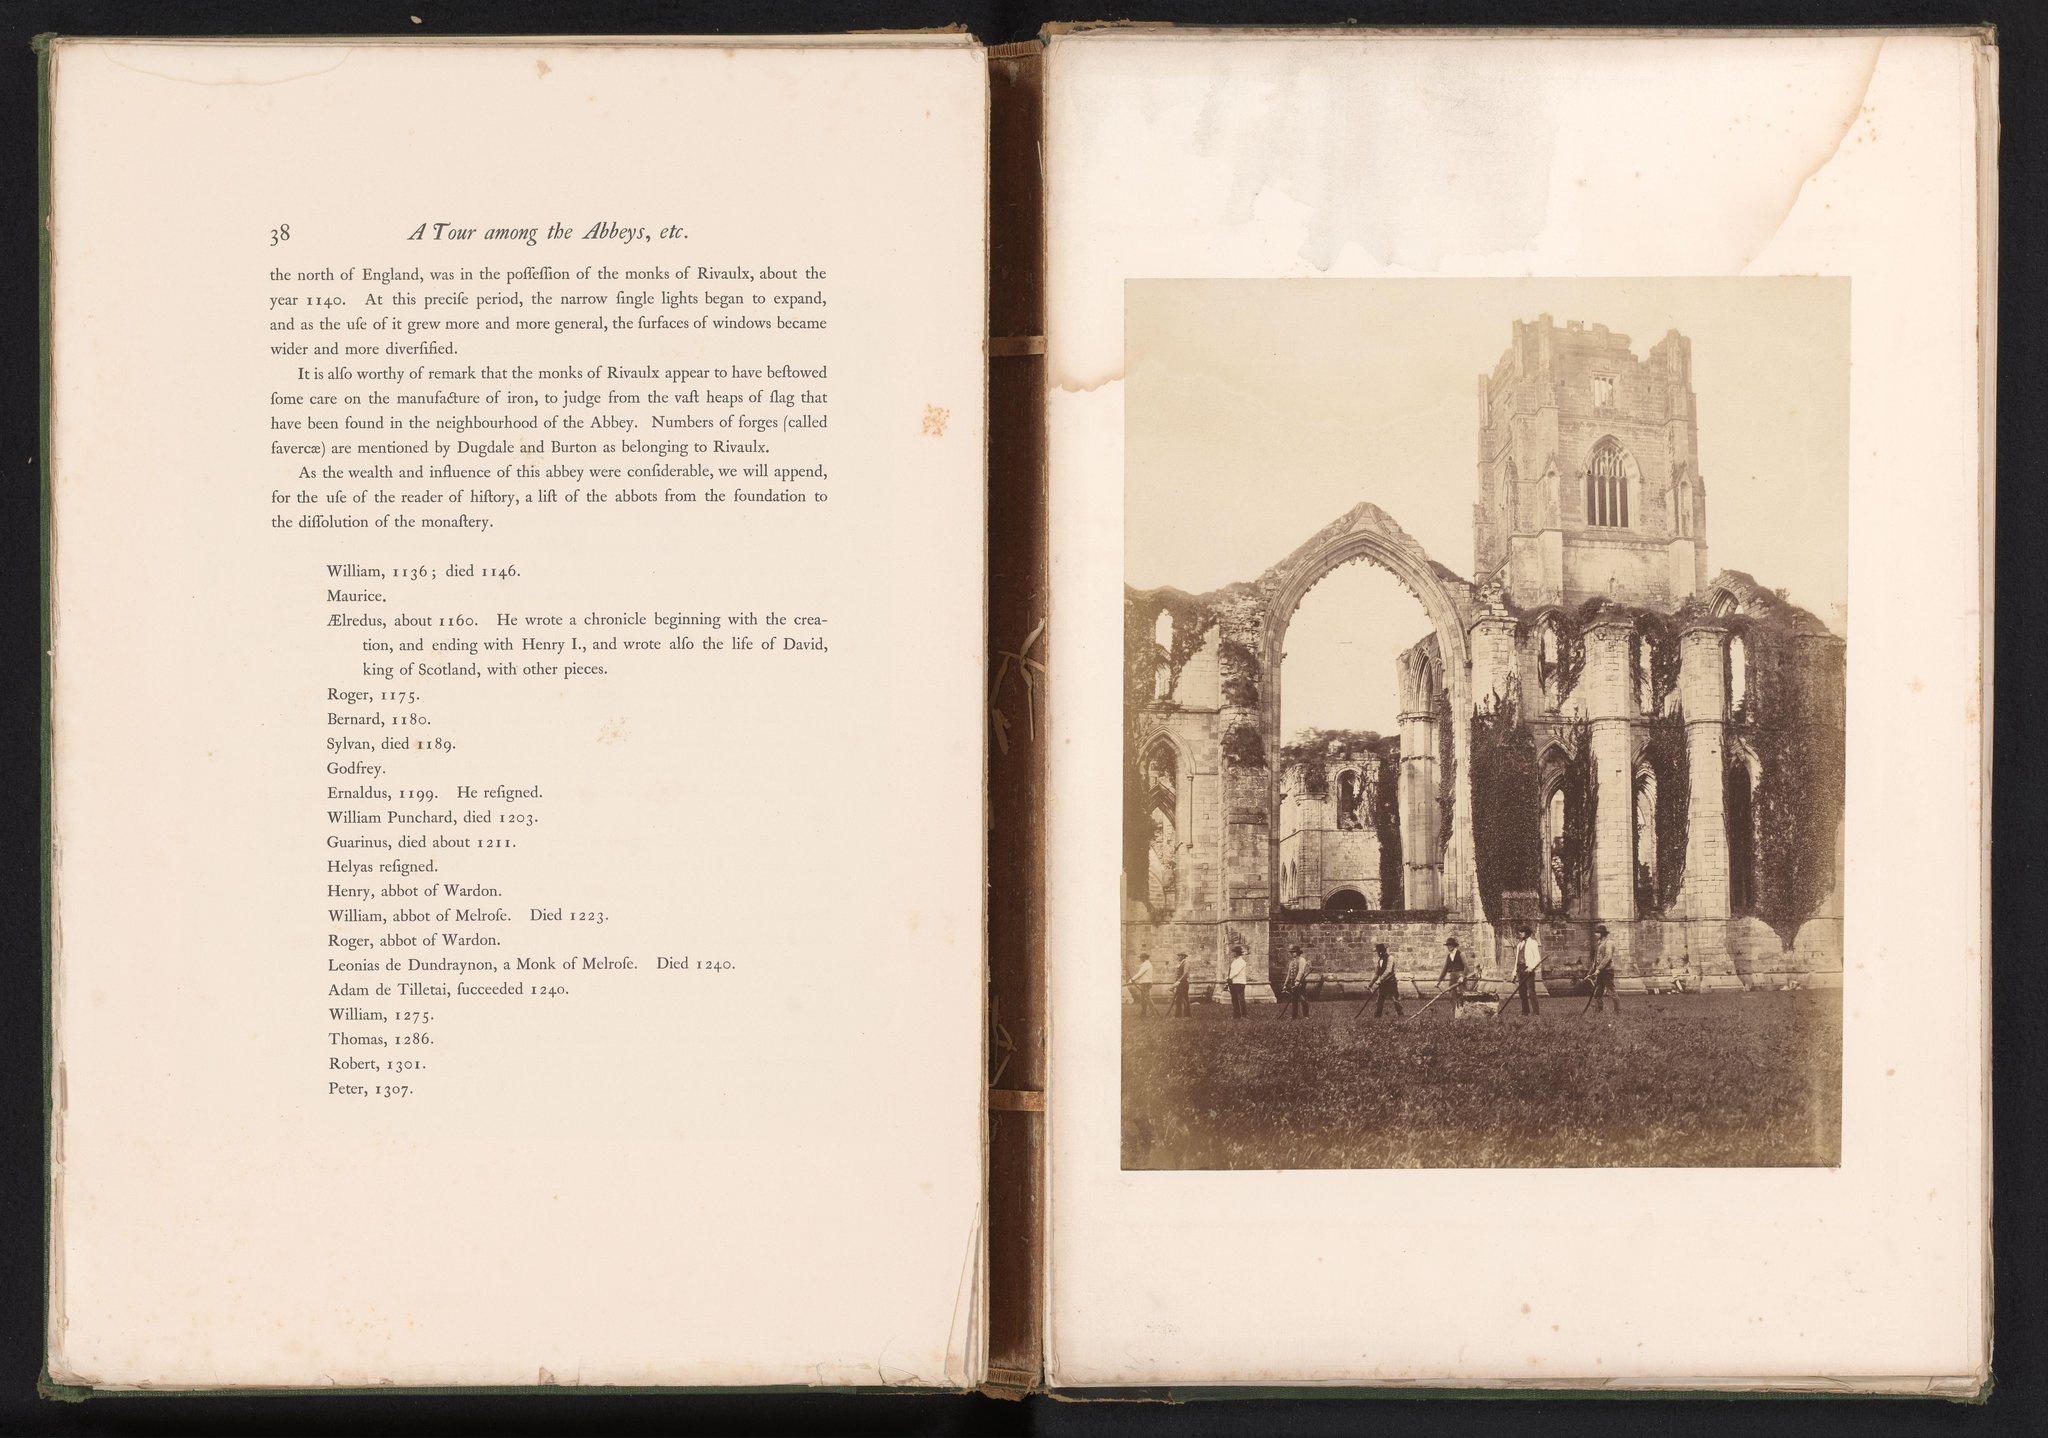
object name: photograph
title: Gezicht op de Abdij van Rievaulx met mannen die het gras maaien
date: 1851-1856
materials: photographic support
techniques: albumen print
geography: yorkshire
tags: reaping, picking, mowing ~ harvest (+ men (labourers)), landscape with ruins, ruin of church, monastery, etc.